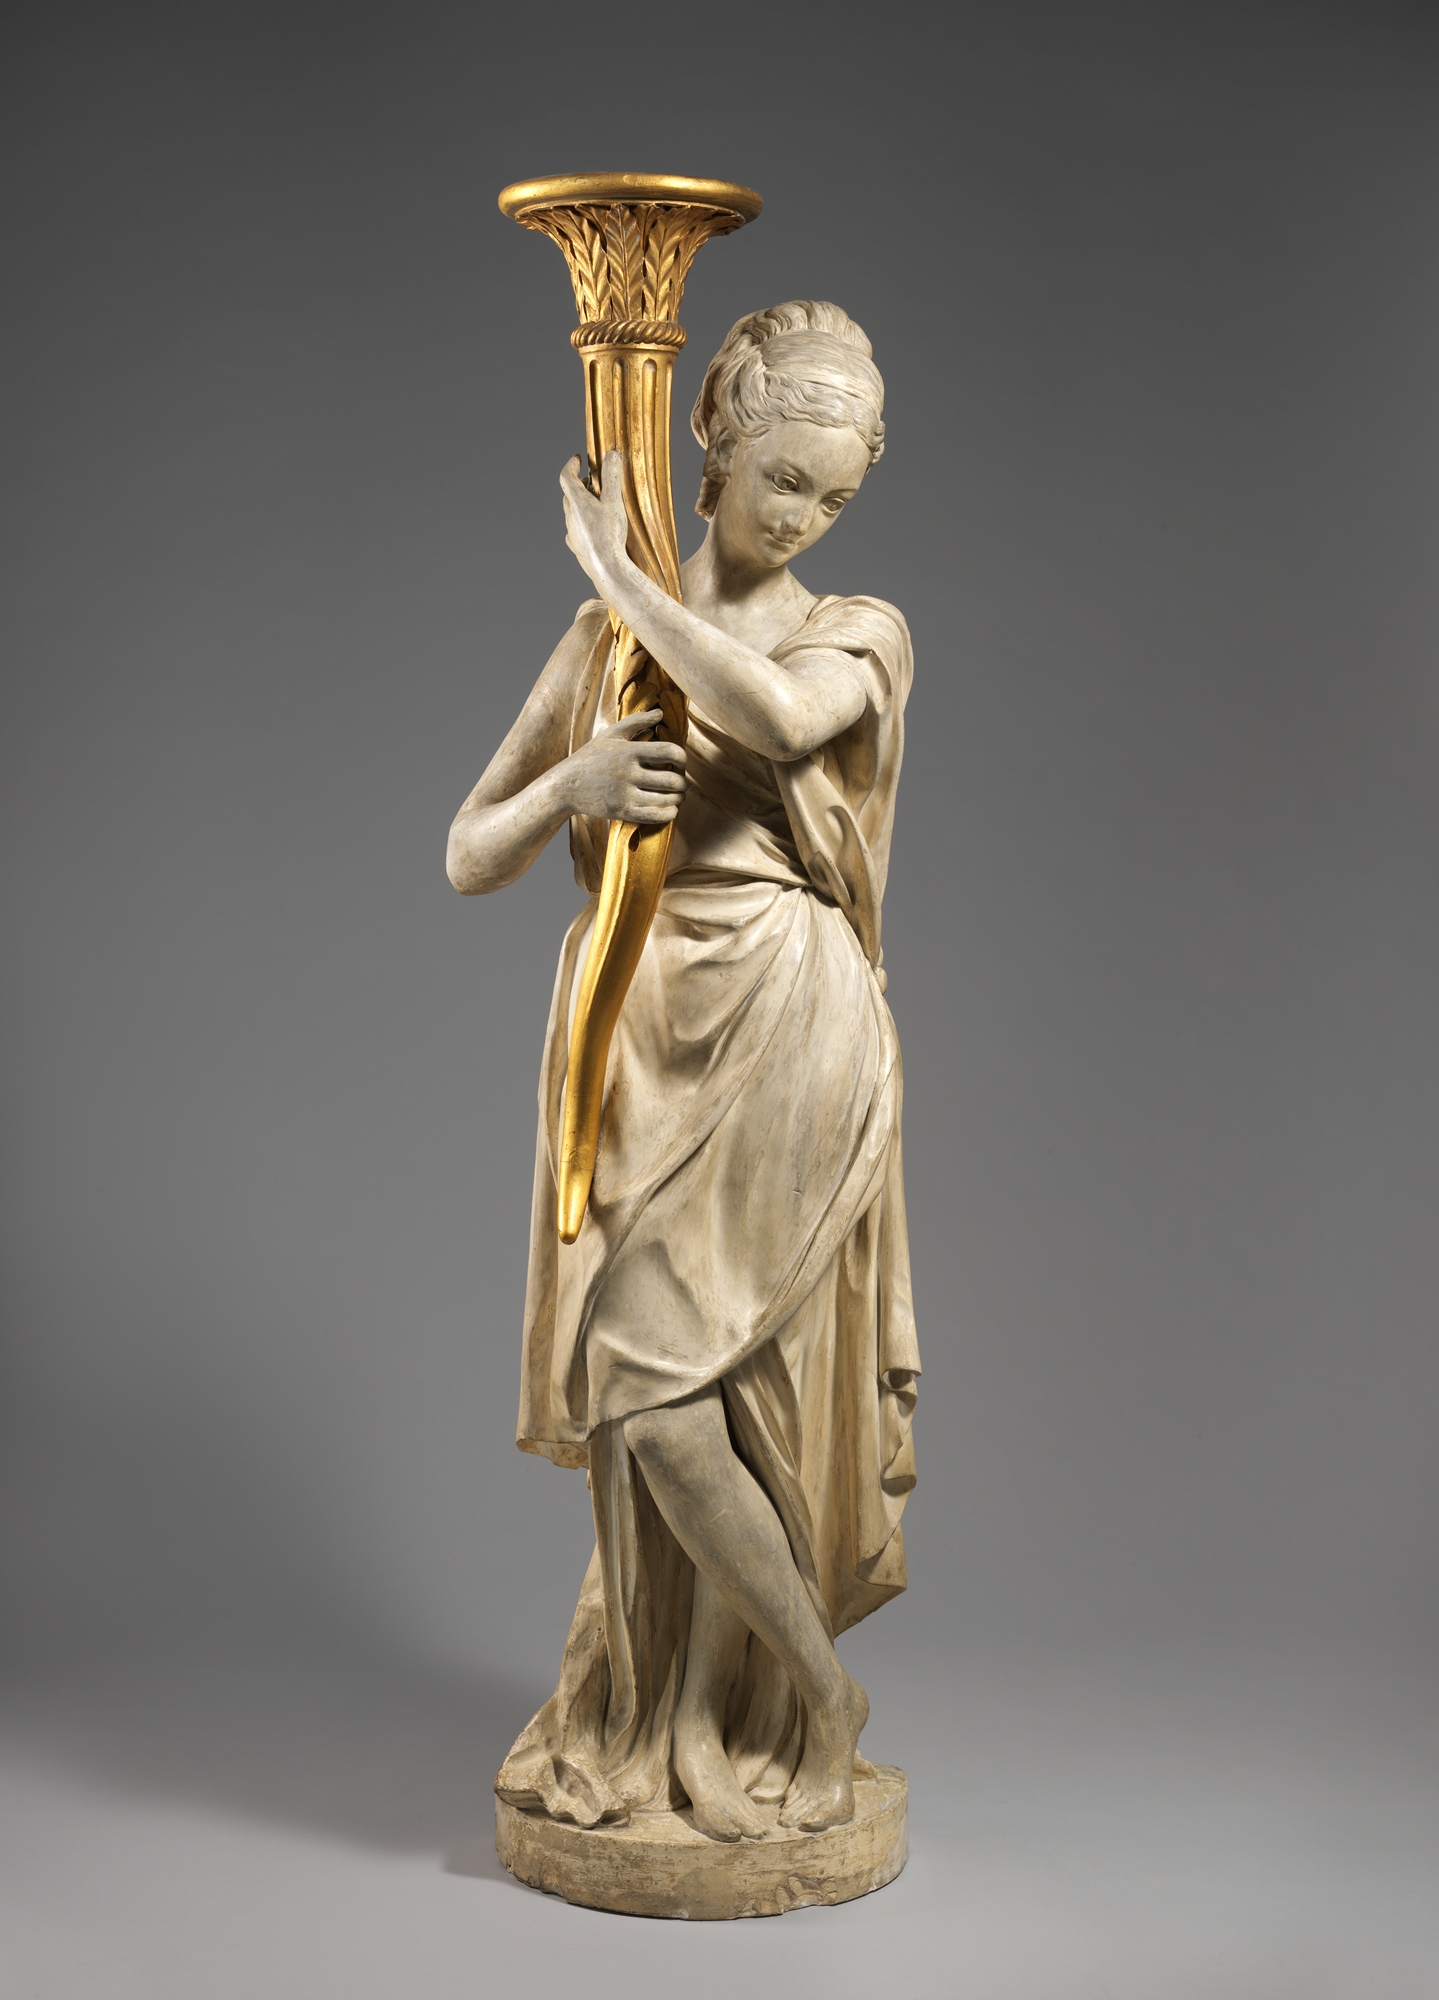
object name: torchère figure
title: Torchère figure (one of a pair)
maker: augustin pajou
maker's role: artist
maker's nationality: french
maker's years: 1730-1809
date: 1801-1900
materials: plaster, wood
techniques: carving, gilding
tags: nymphs